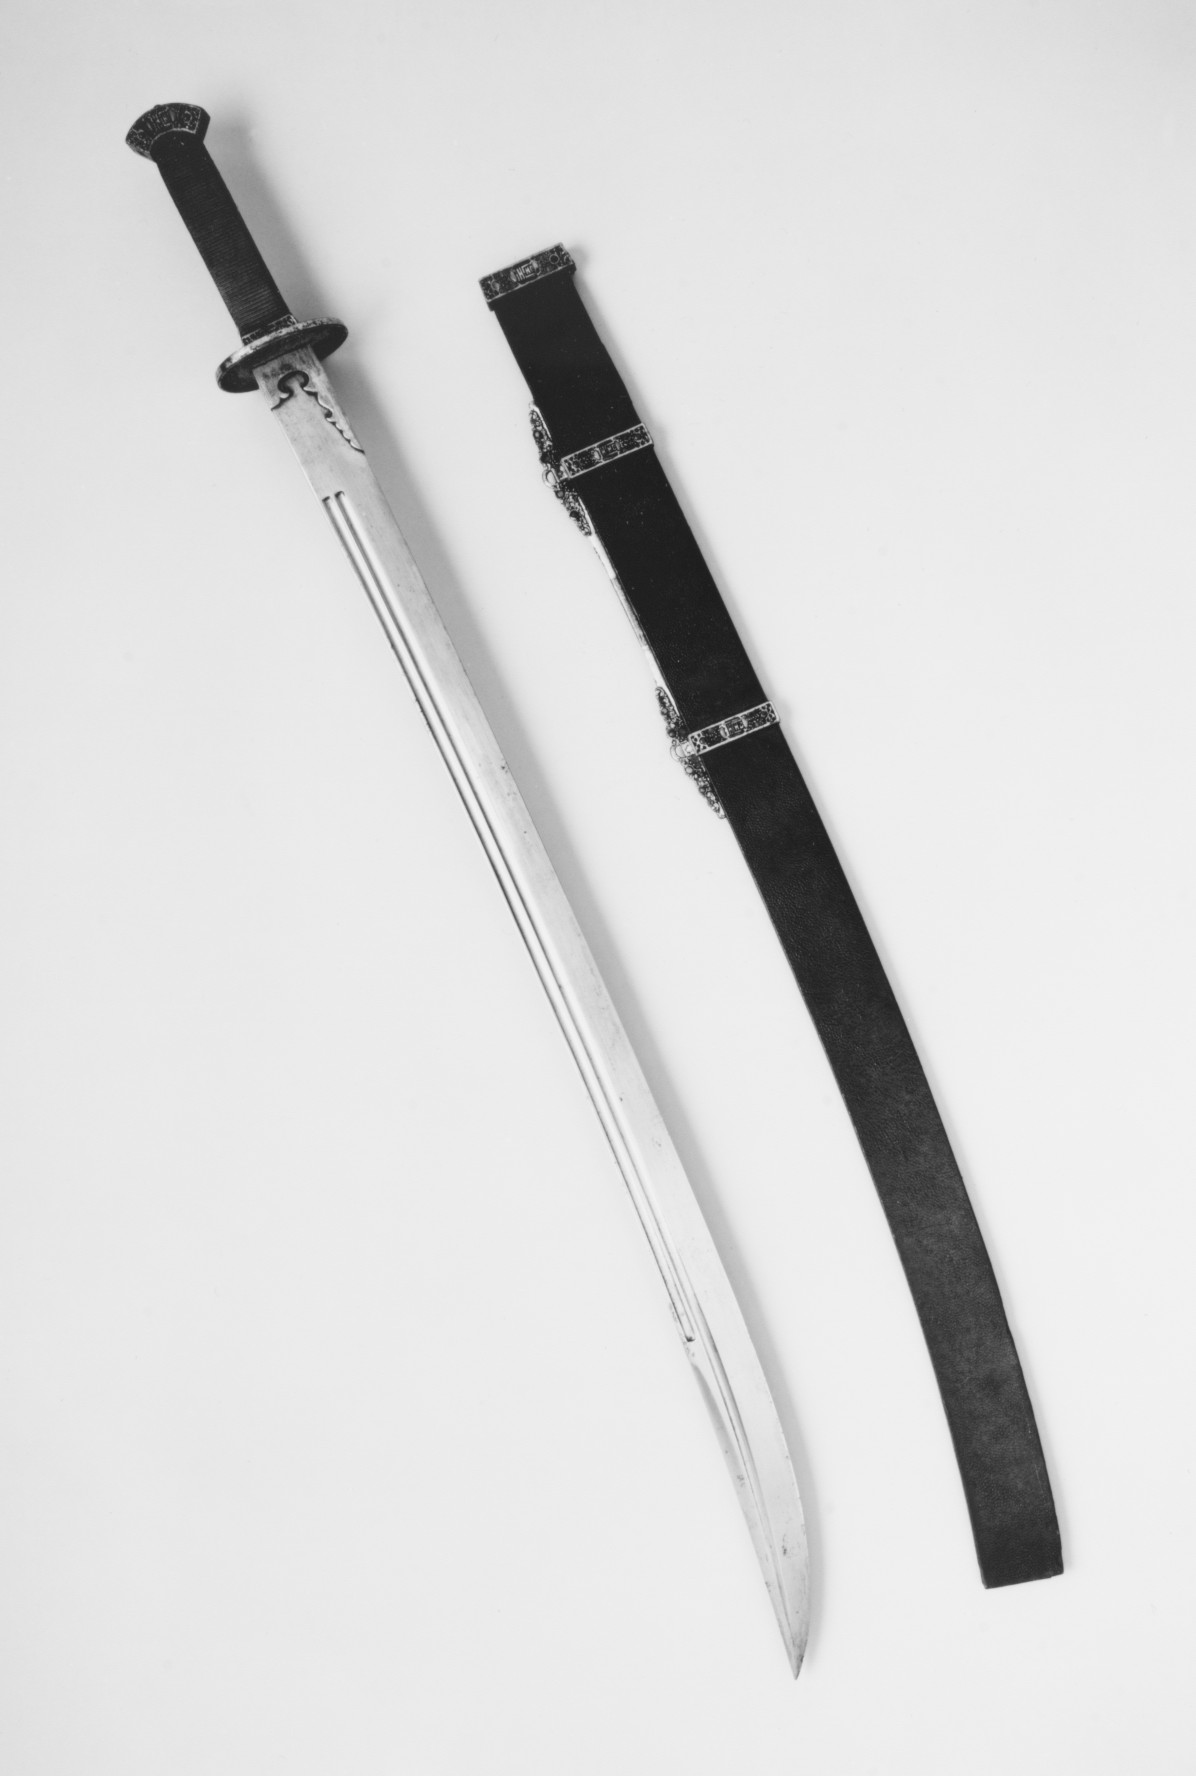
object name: sword with scabbard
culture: chinese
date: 1601-1700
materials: coral, gold, mother of pearl, skin, steel, stone, textile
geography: china